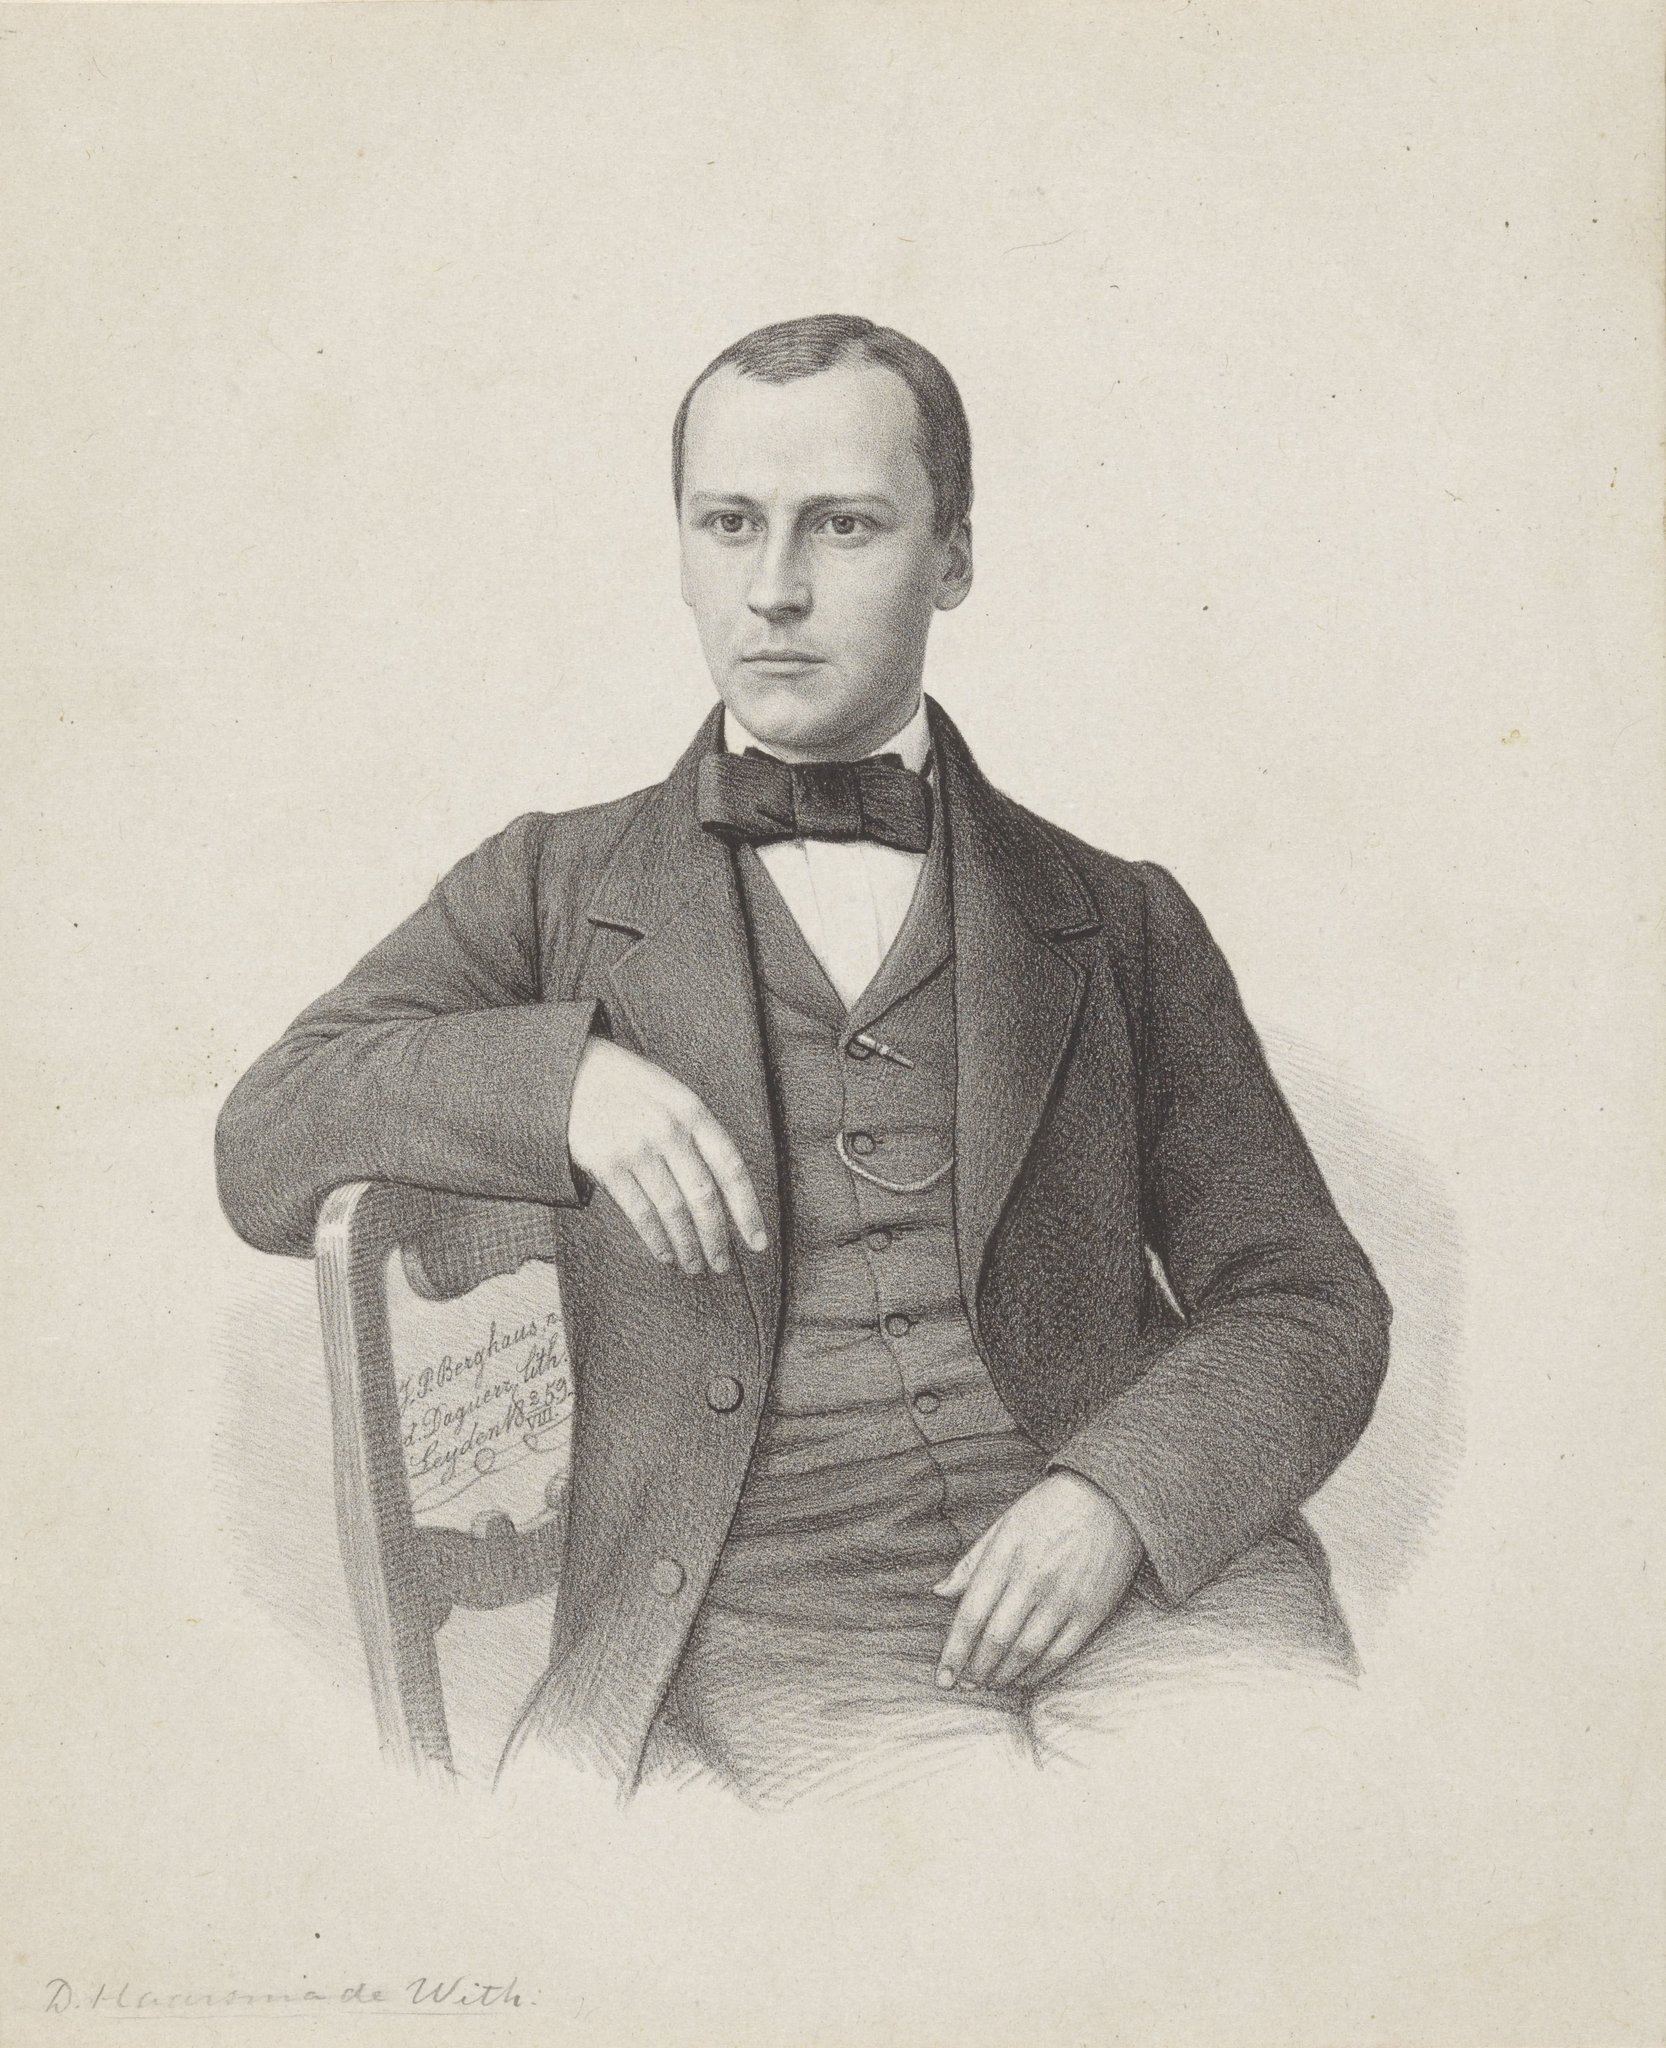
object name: print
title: Portret van een onbekende man, mogelijk D. Haarsma de Wit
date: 1859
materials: paper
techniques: lithograph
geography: leiden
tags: historical persons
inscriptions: date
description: De geportretteerde zit en leunt met zijn rechterarm op de rug van de stoel.